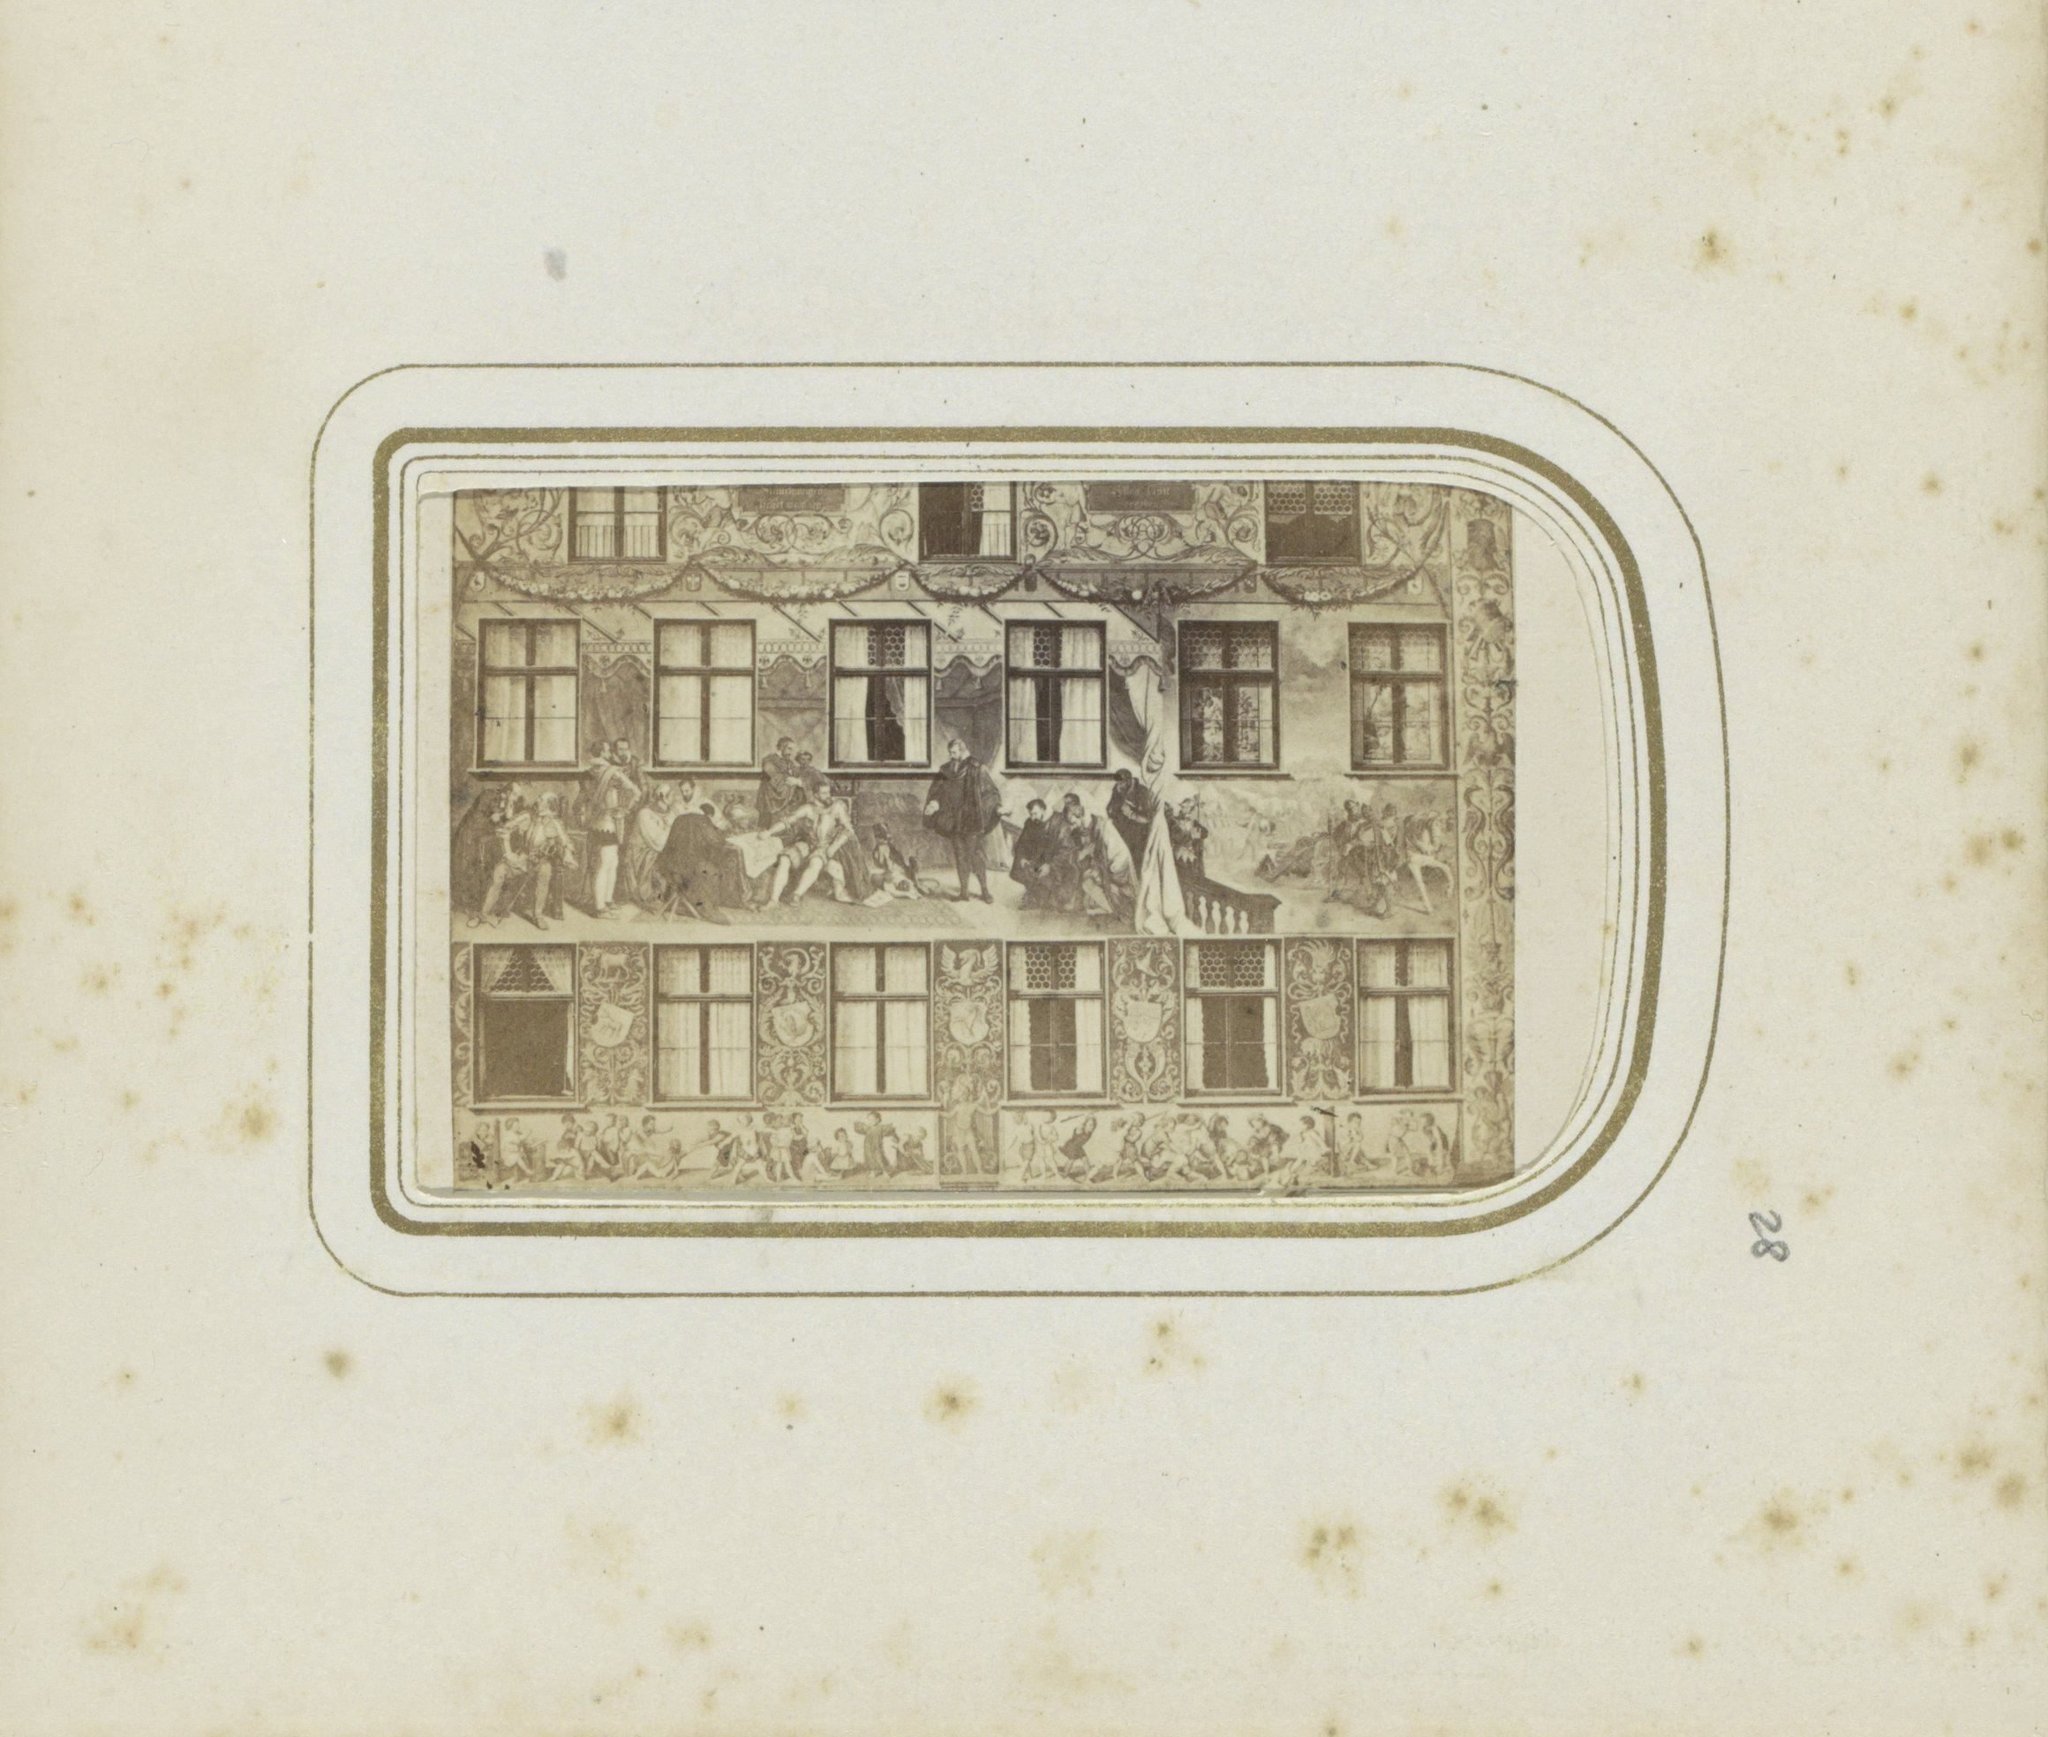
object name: photograph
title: Fresco op een gevel van het voormalige woonhuis van Hans Jakob Fugger in Augsburg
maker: Anonymous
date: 1865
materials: paper, photographic support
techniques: albumen print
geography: augsburg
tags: painting (including book-illumination, miniature-painting) (+ plaster ~ arts), travelling; tourism, augsburg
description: Onderdeel van Fotoalbum van een reis door Zwitserland, Oostenrijk en Duitsland door de Nederlandse familie Derkinderen.